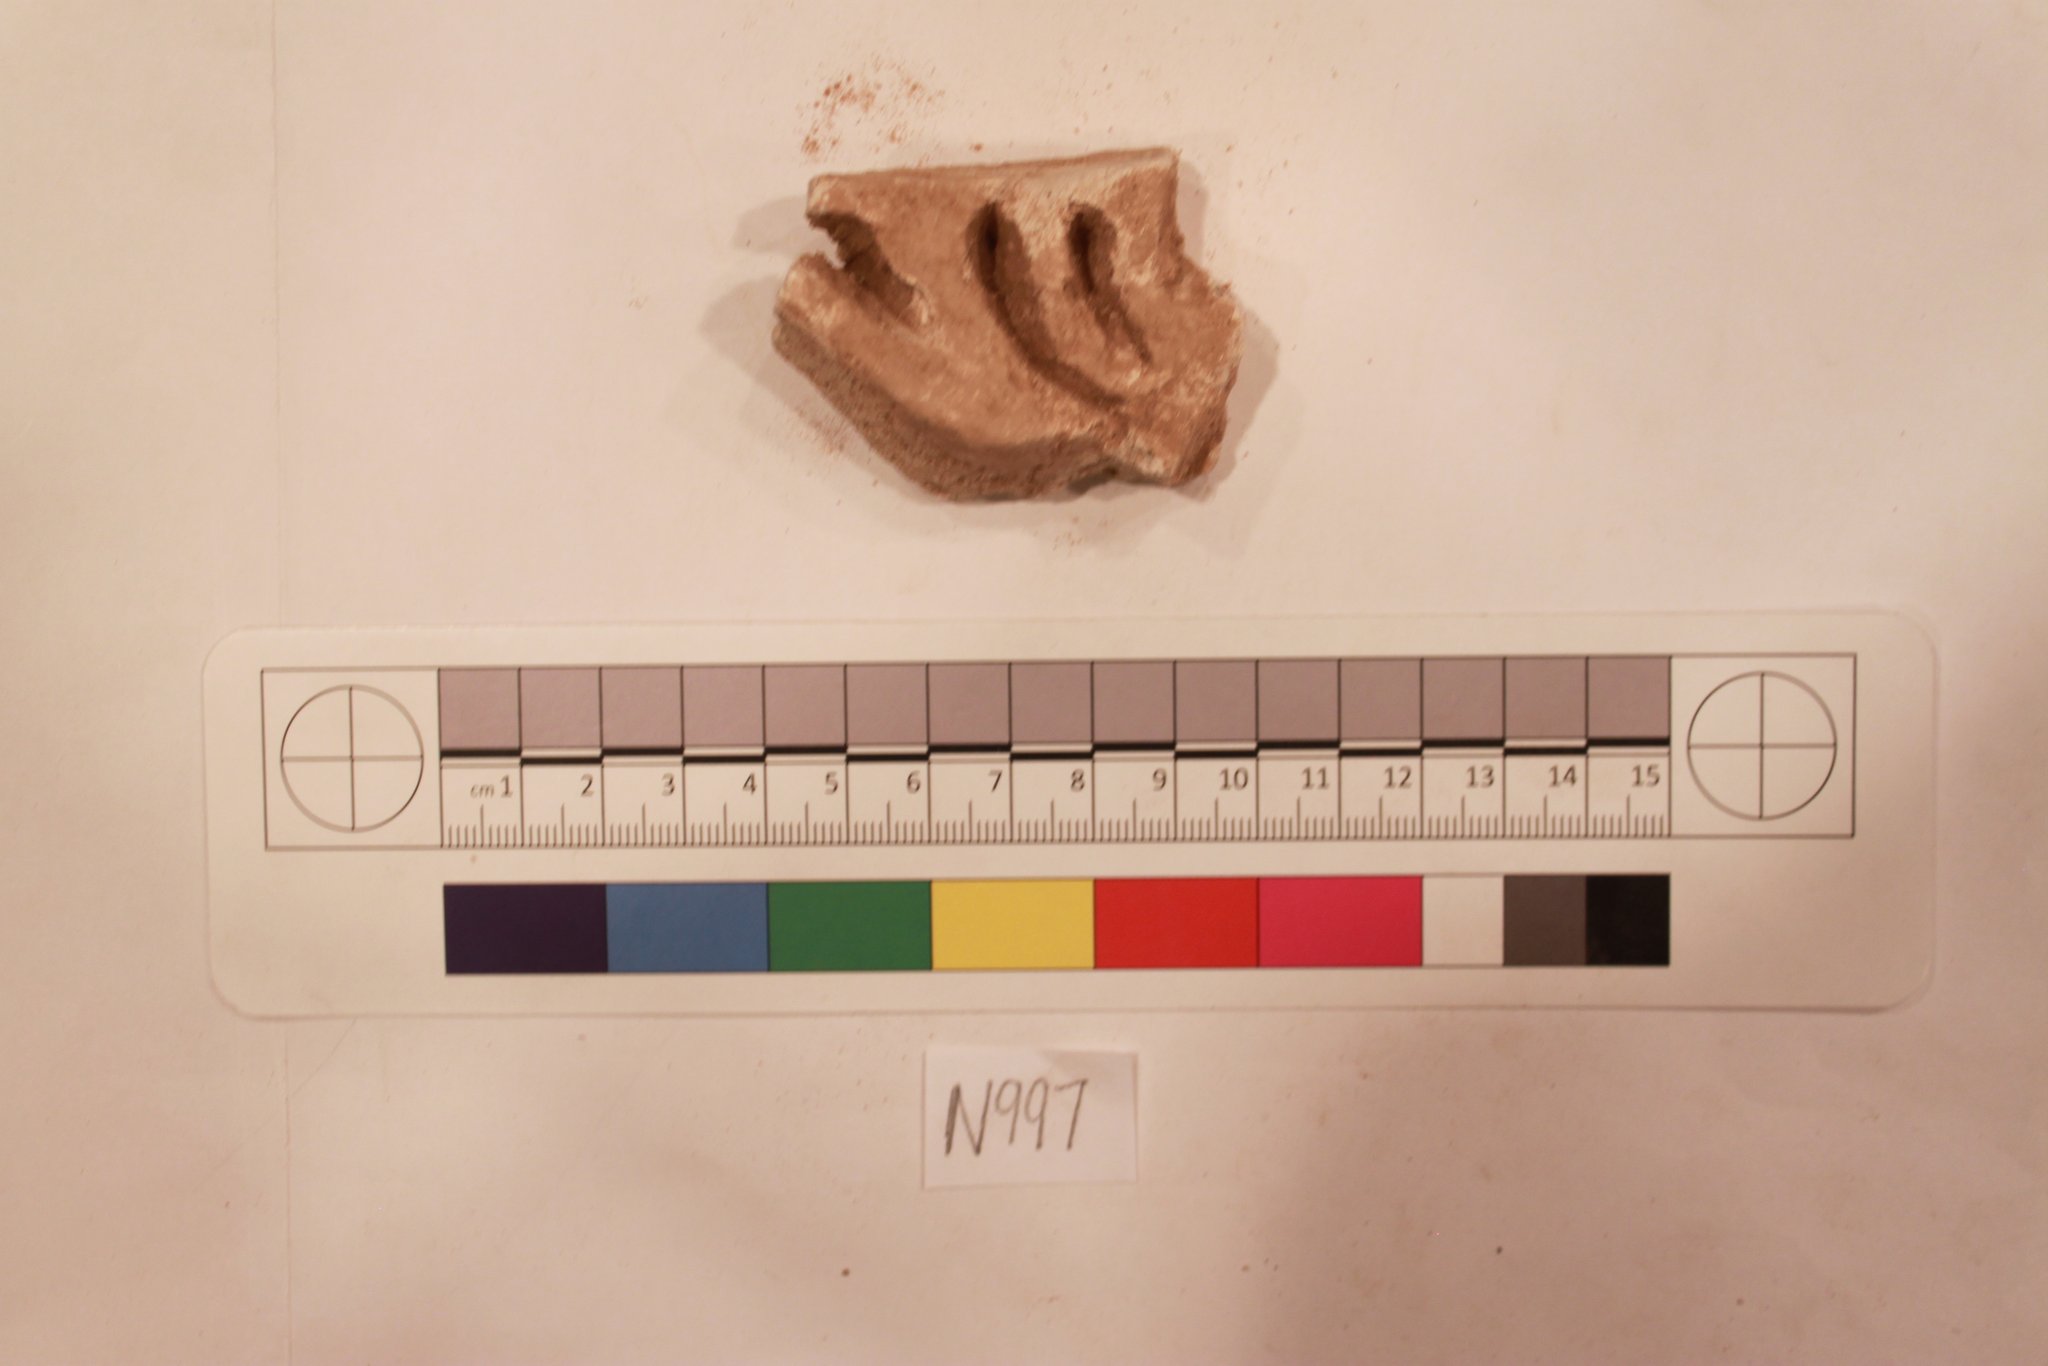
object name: fragment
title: Stucco Fragment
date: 701-1200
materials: plaster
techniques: carving, painting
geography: iran